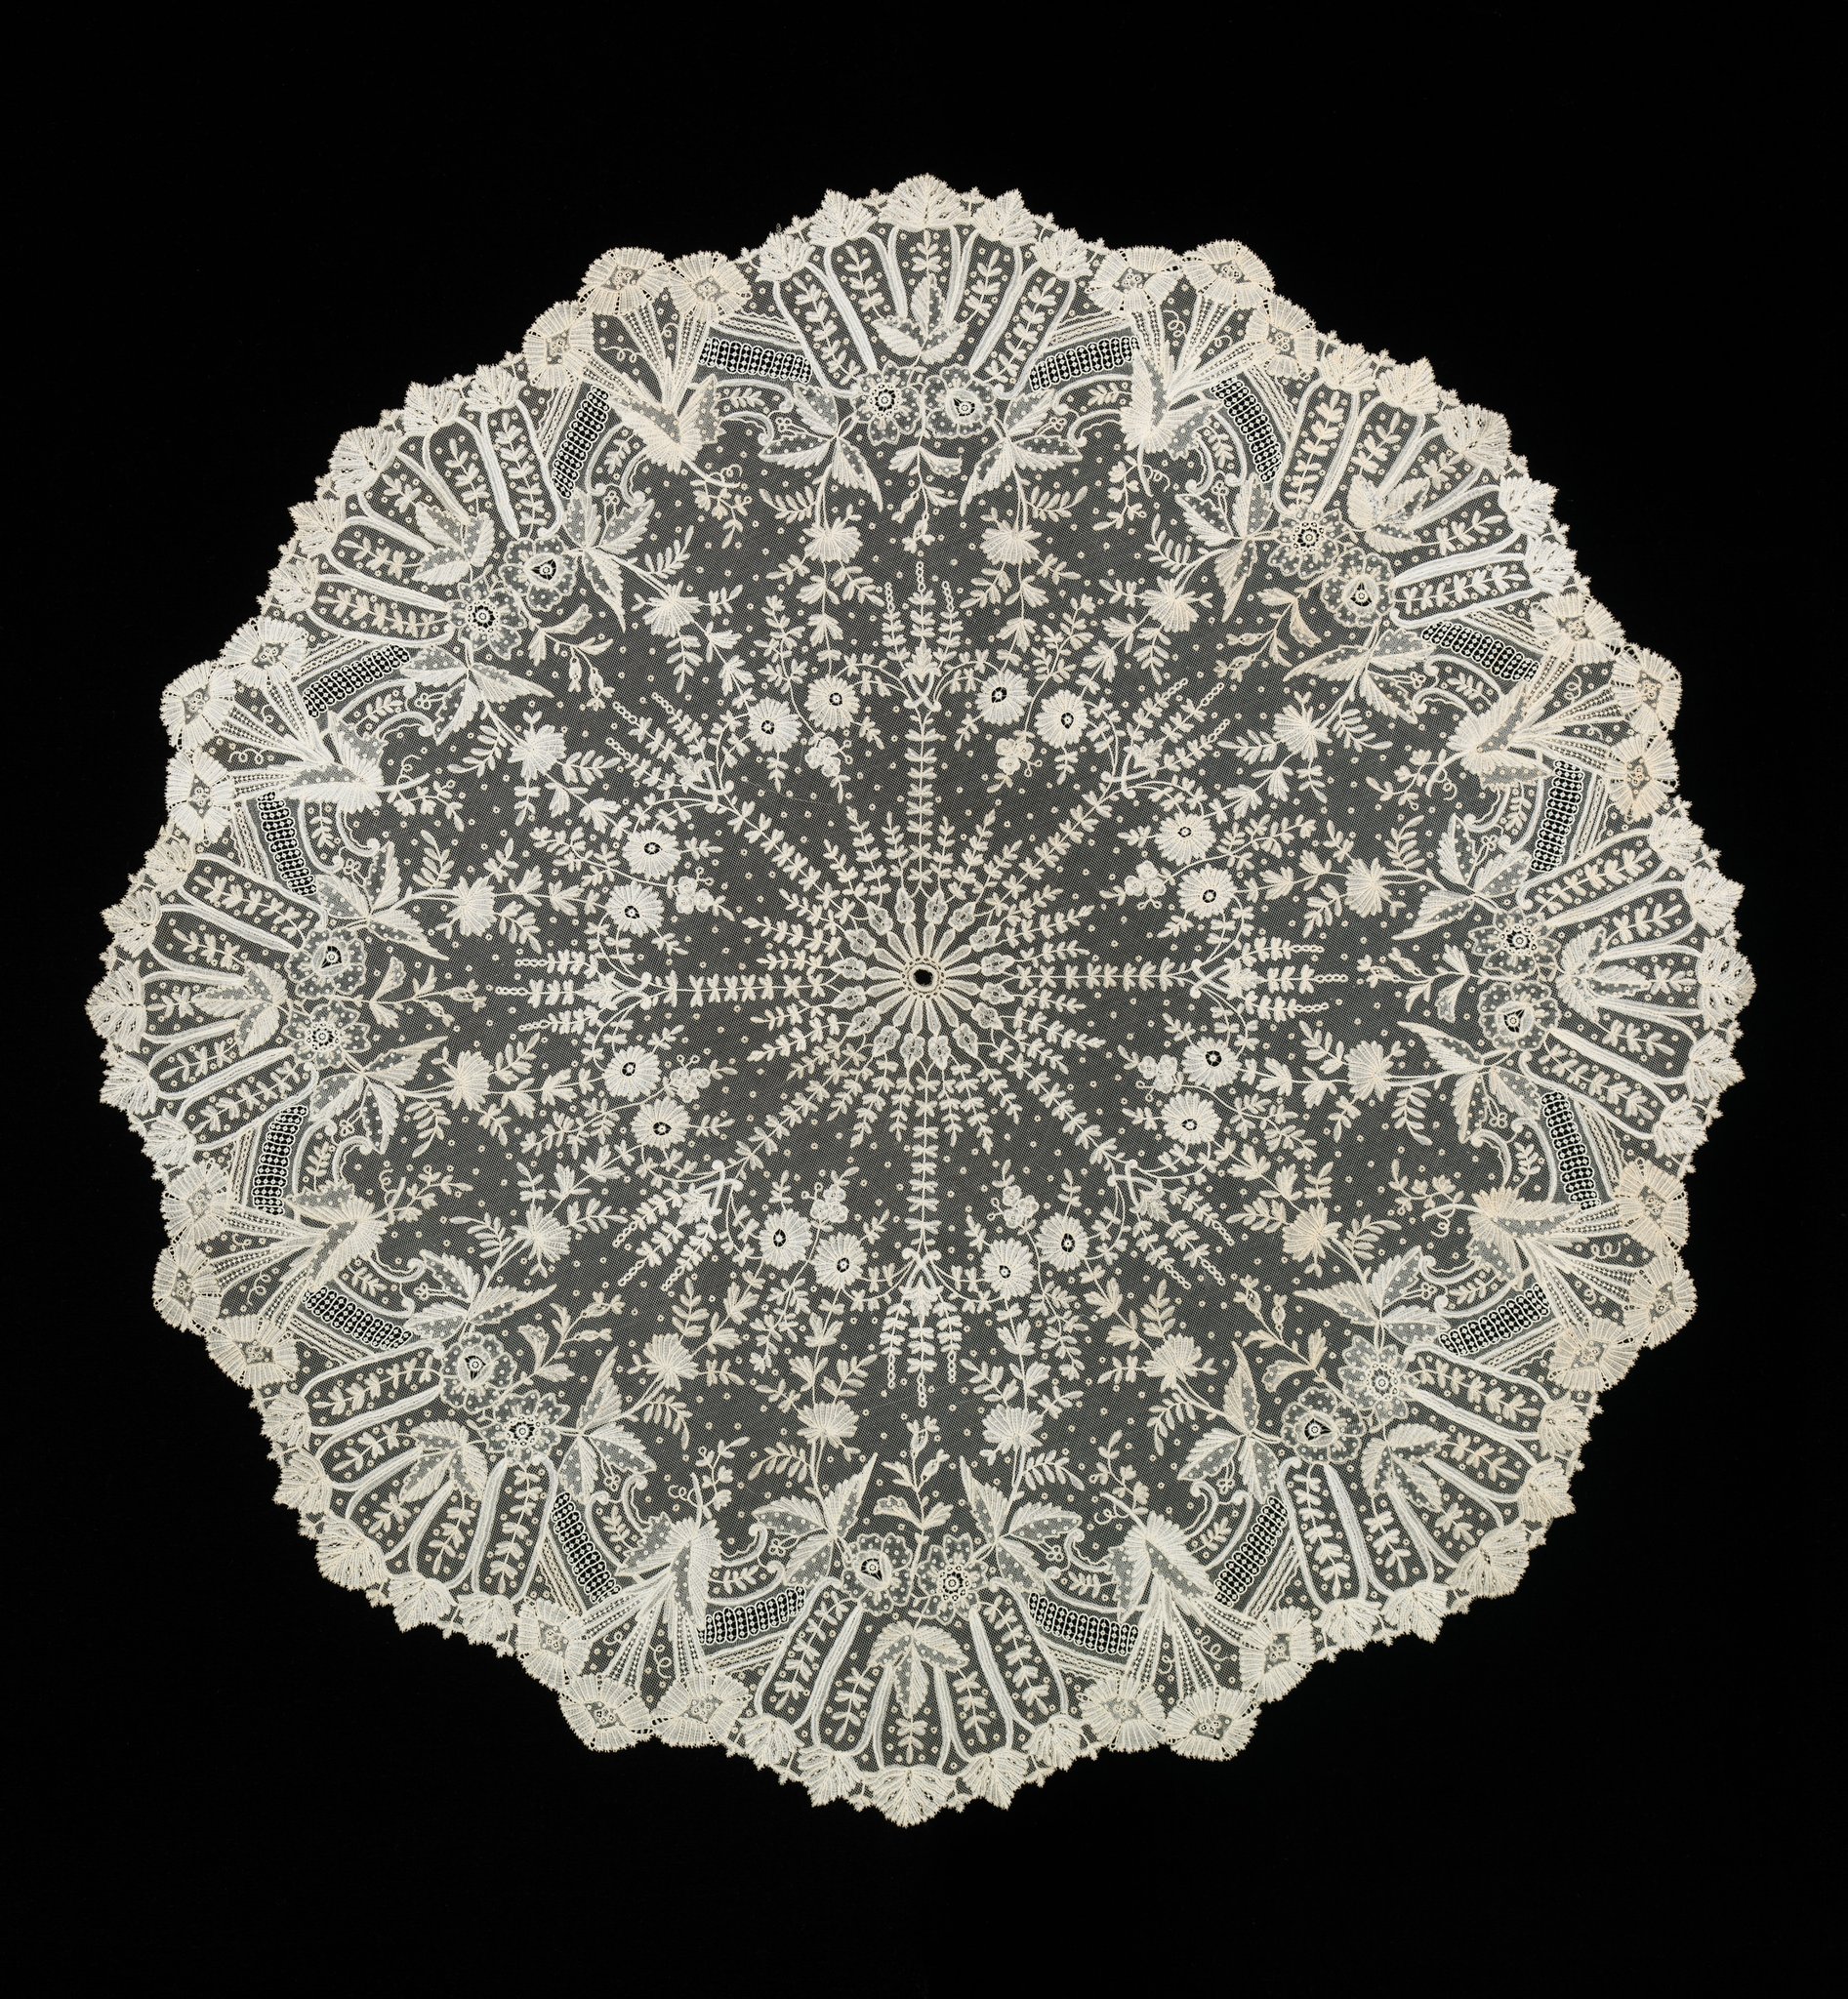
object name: parasol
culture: belgian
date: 1880-1889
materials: linen, silk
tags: flowers